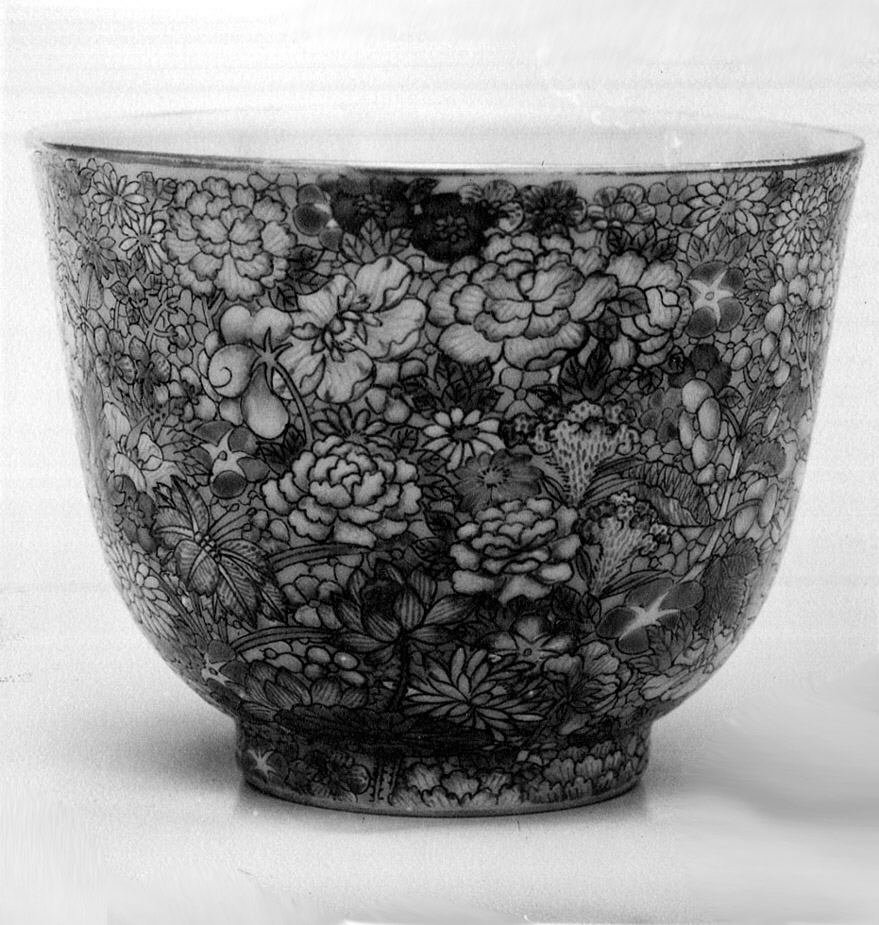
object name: cup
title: One of a Pair of Cups with Mille-Fleurs Design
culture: chinese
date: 1796-1820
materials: enamel, porcelain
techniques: overglaze, painting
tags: flowers